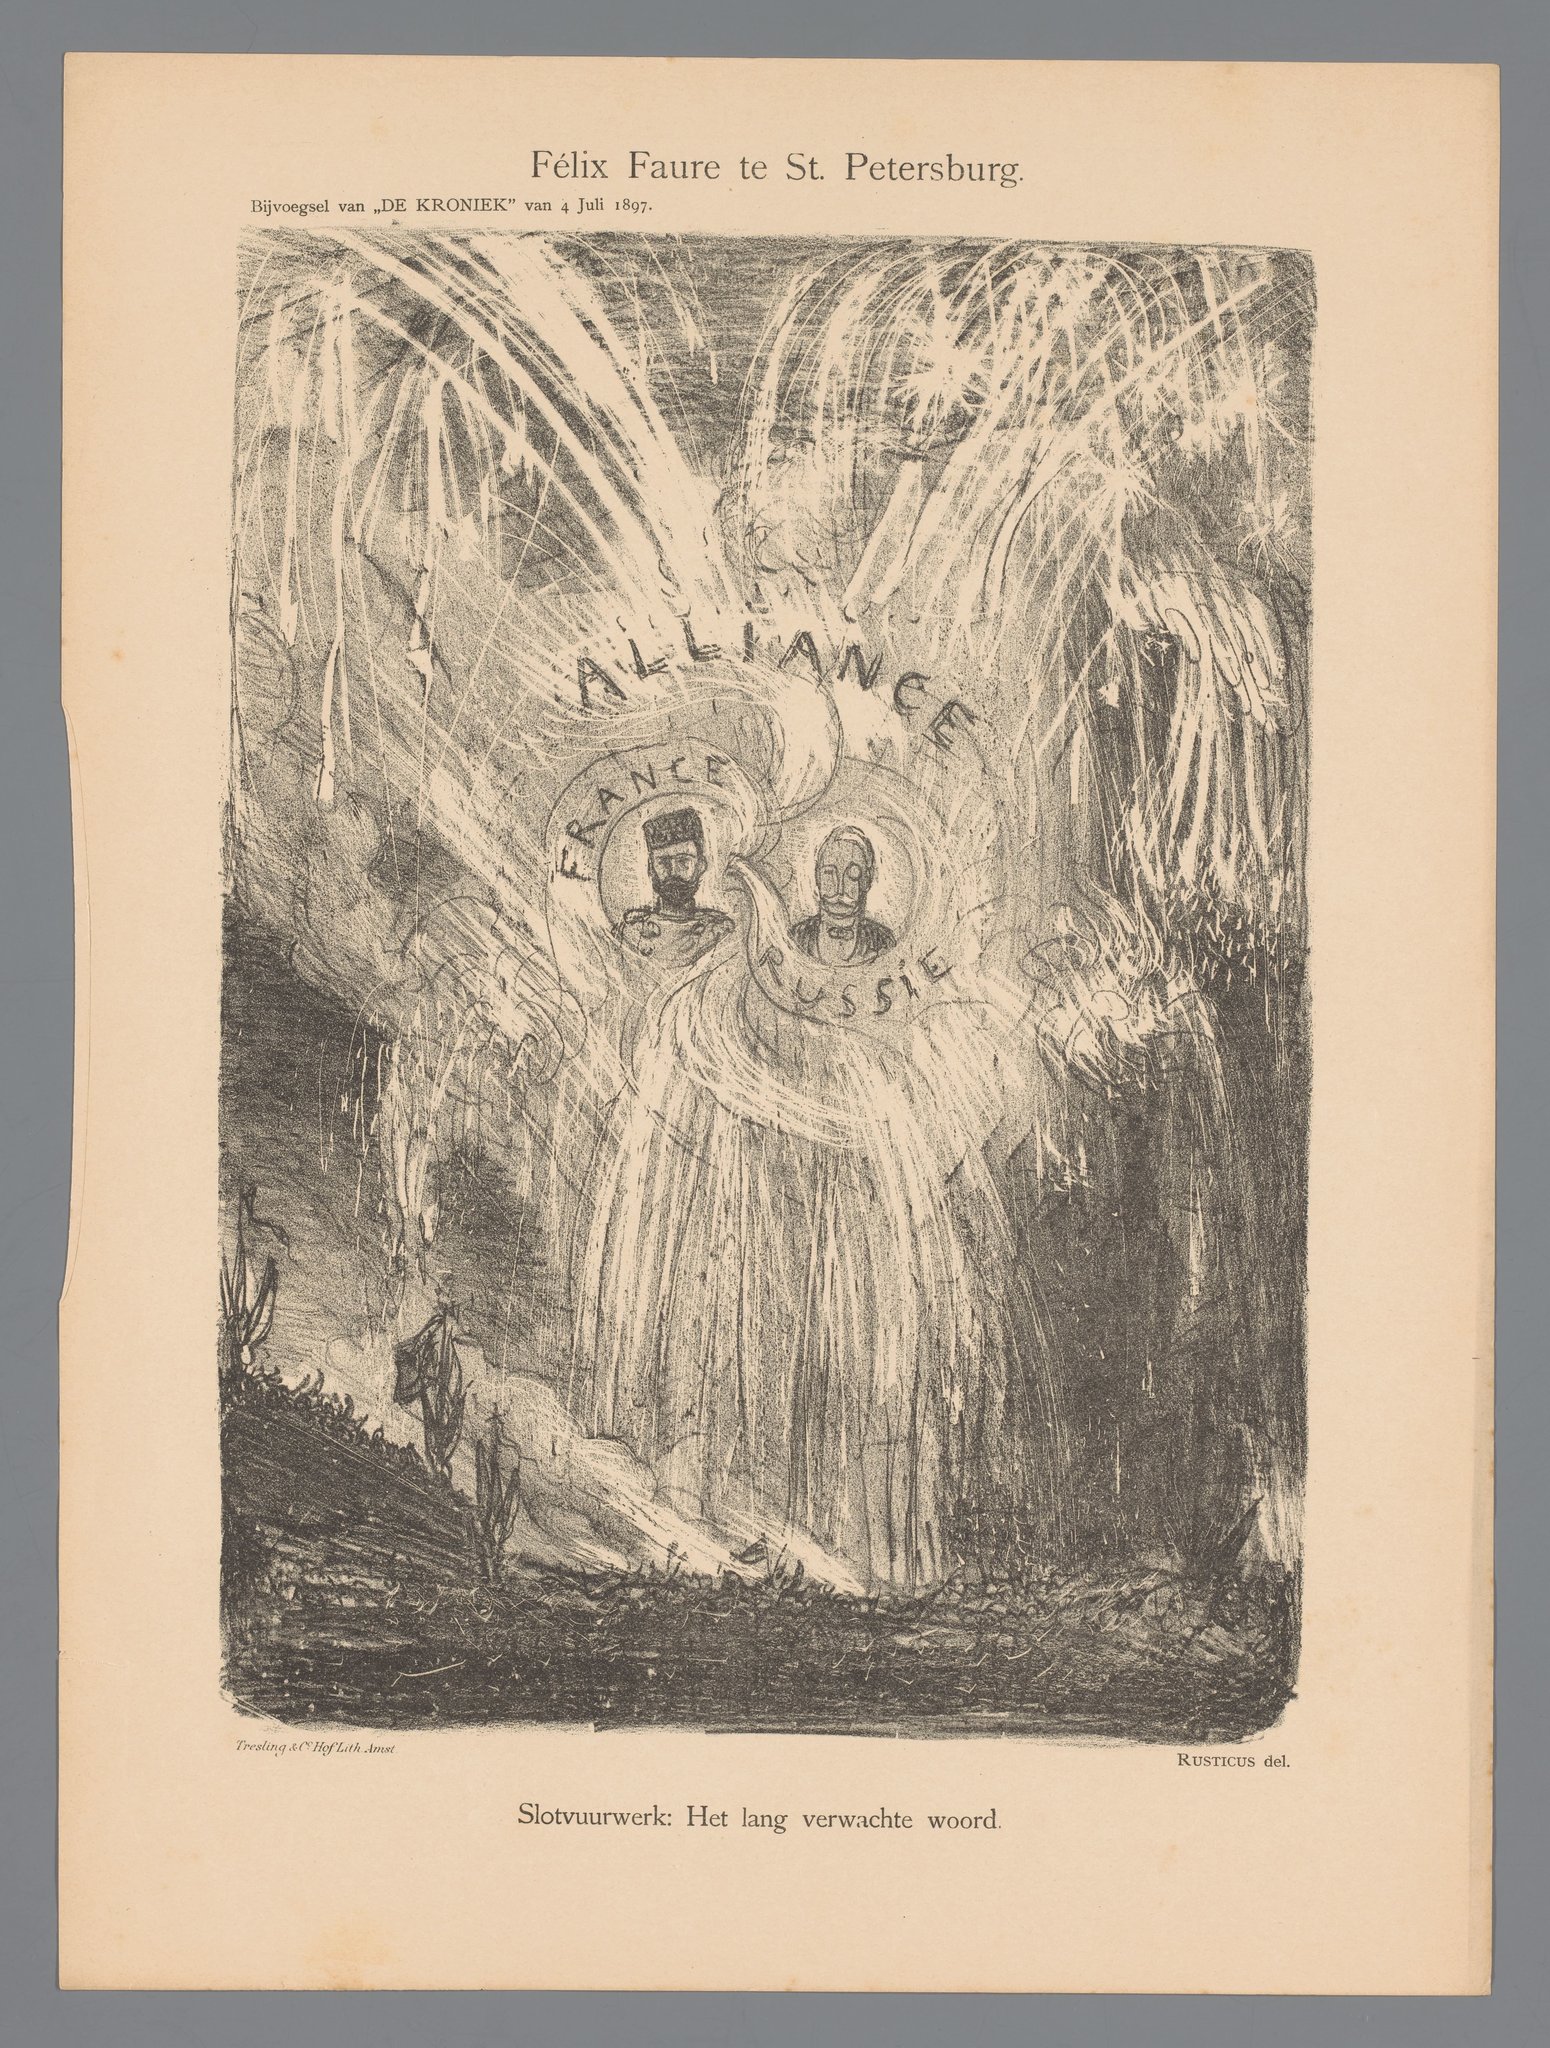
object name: print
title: Felix Faure te St. Petersburg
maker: marius bauer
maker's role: draughtsman, print maker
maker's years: 1867-1932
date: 1897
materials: paper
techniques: lithograph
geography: amsterdam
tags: paris, bonfire, fire-works, political caricatures and satires, russia, france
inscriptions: date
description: Spotprent op de alliantie tussen Frankrijk en Rusland. Tusen het vuurwerk in de lucht portretten van de Franse president Félix Faure en de Russische tsaar Nicolaas II.